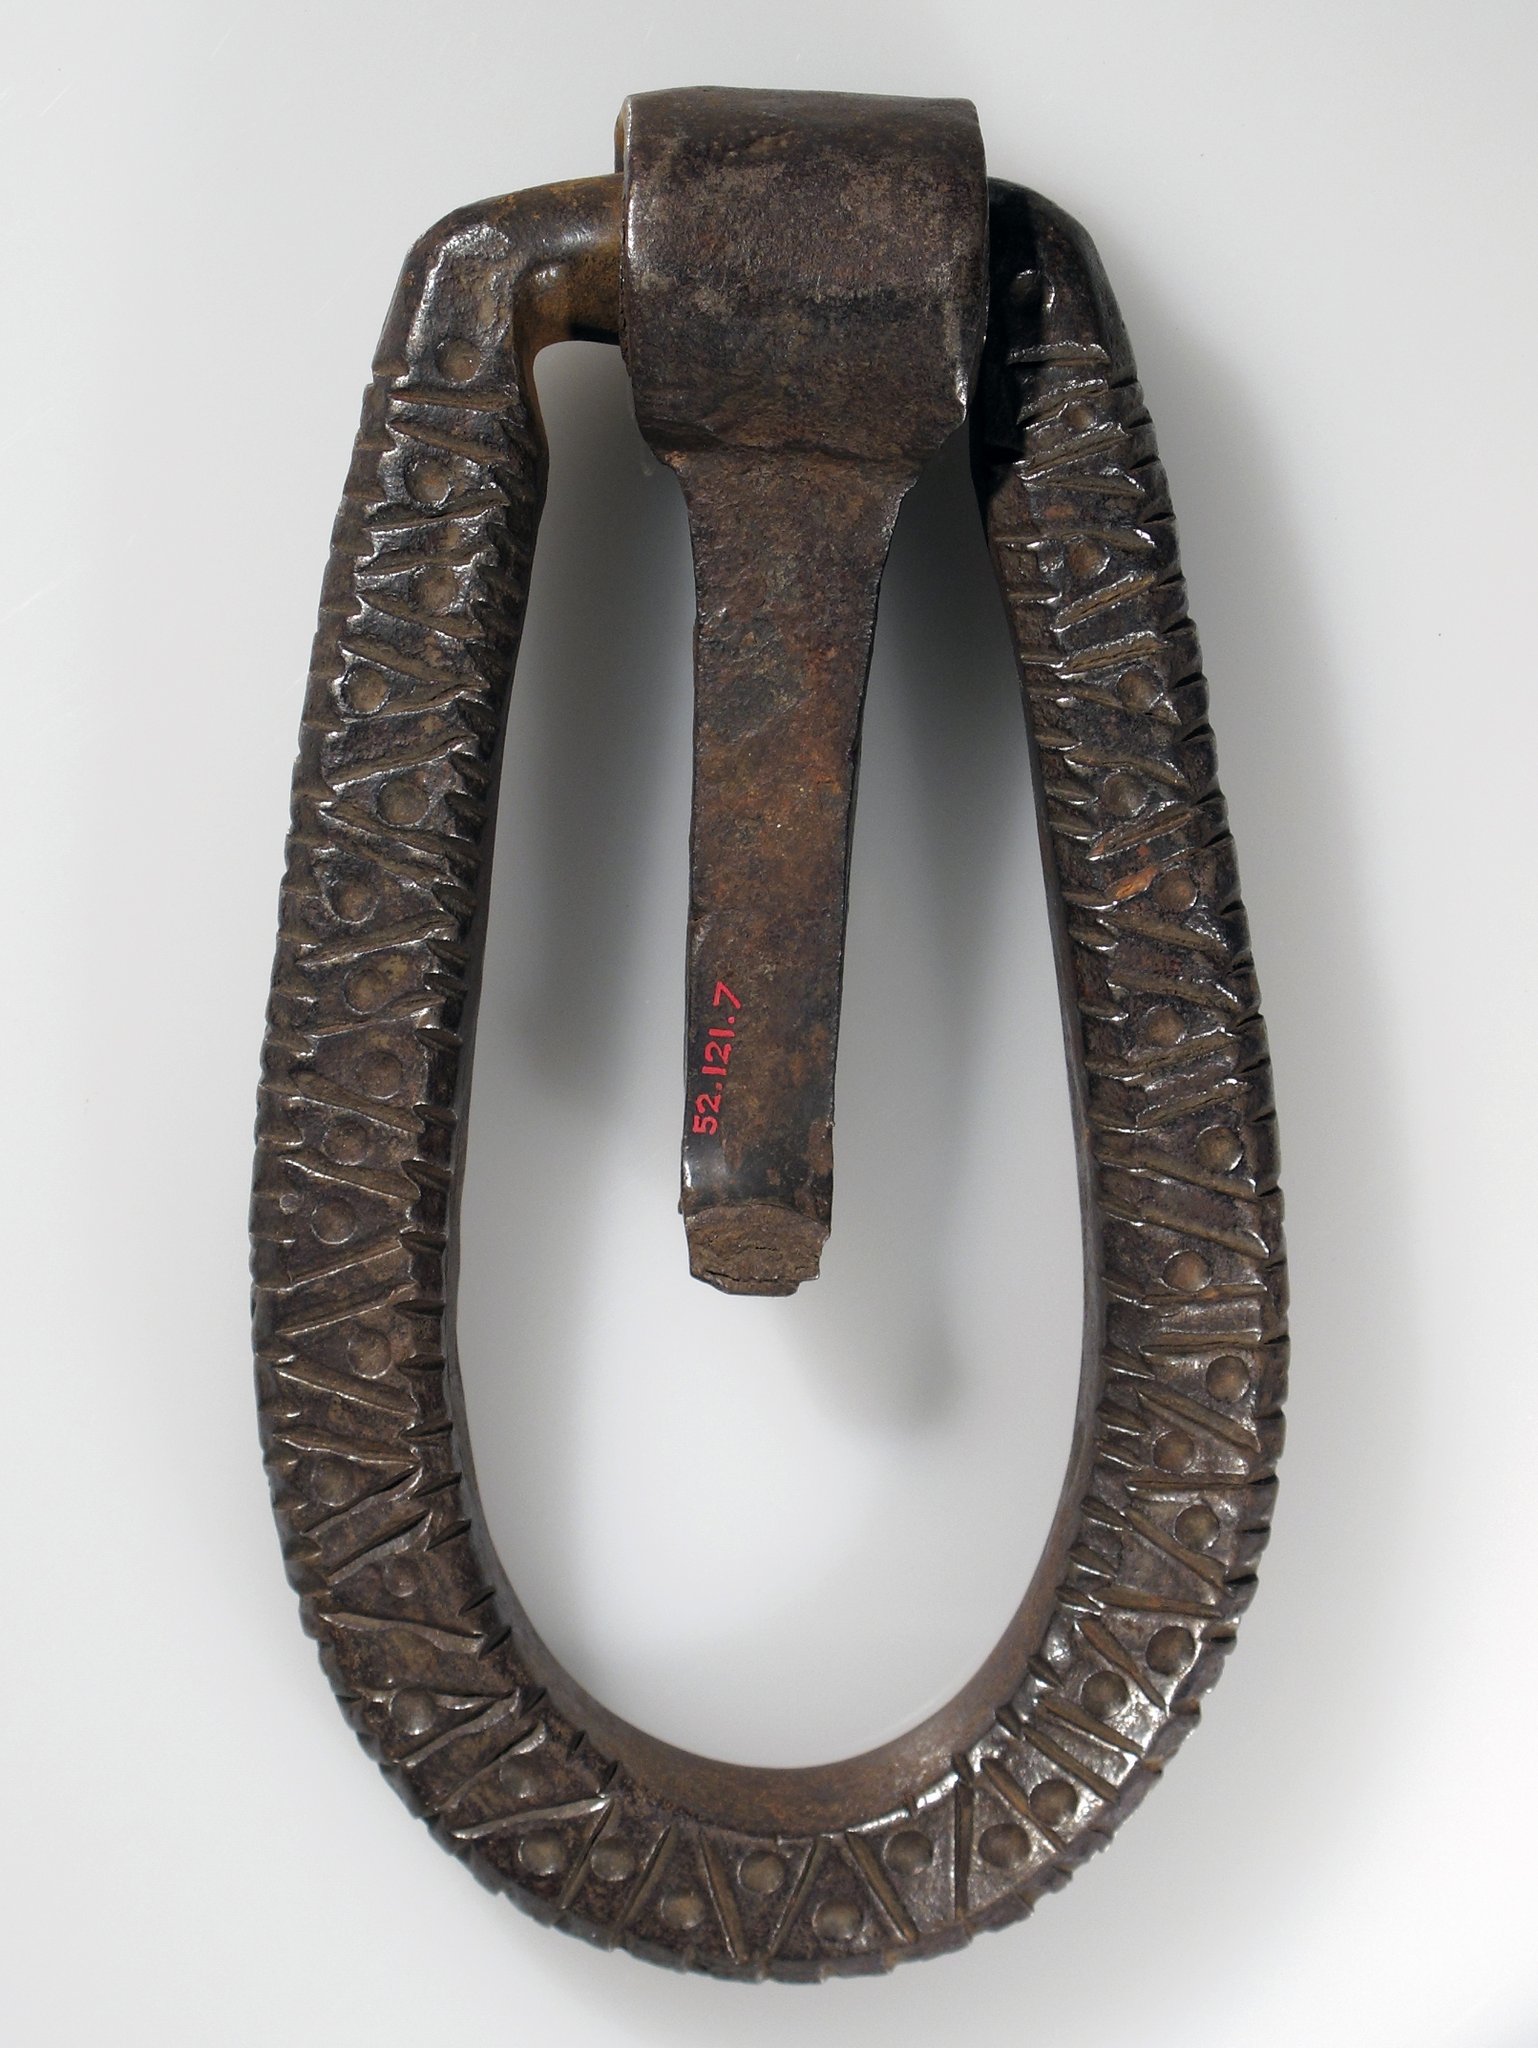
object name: door knocker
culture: european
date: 1401-1600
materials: iron